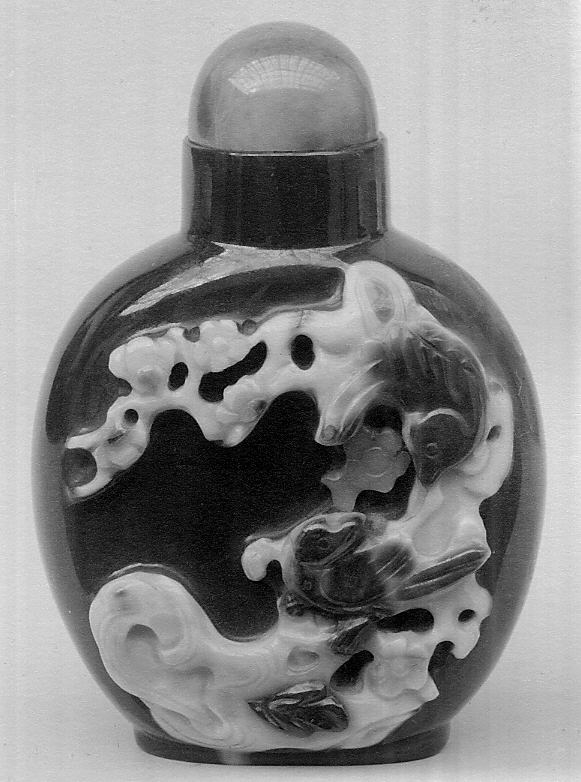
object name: snuff bottle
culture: chinese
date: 1736-1795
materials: stone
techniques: cutting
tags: birds